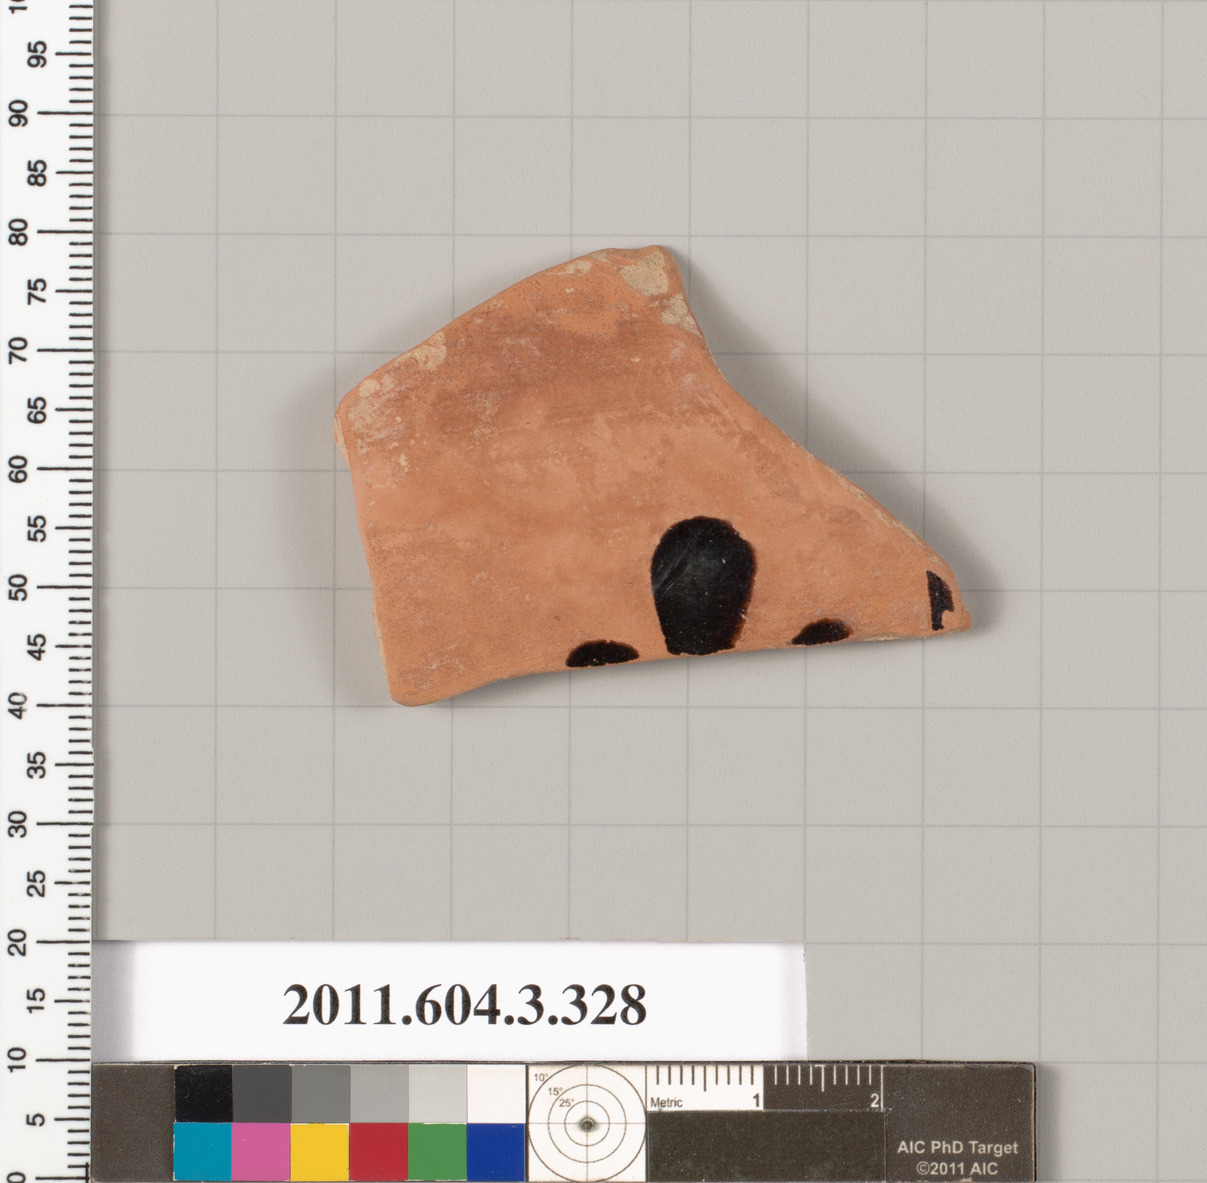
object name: neck amphora fragment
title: Terracotta fragment of a neck-amphora (jar)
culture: greek, attic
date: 525-501 BCE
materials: terracotta